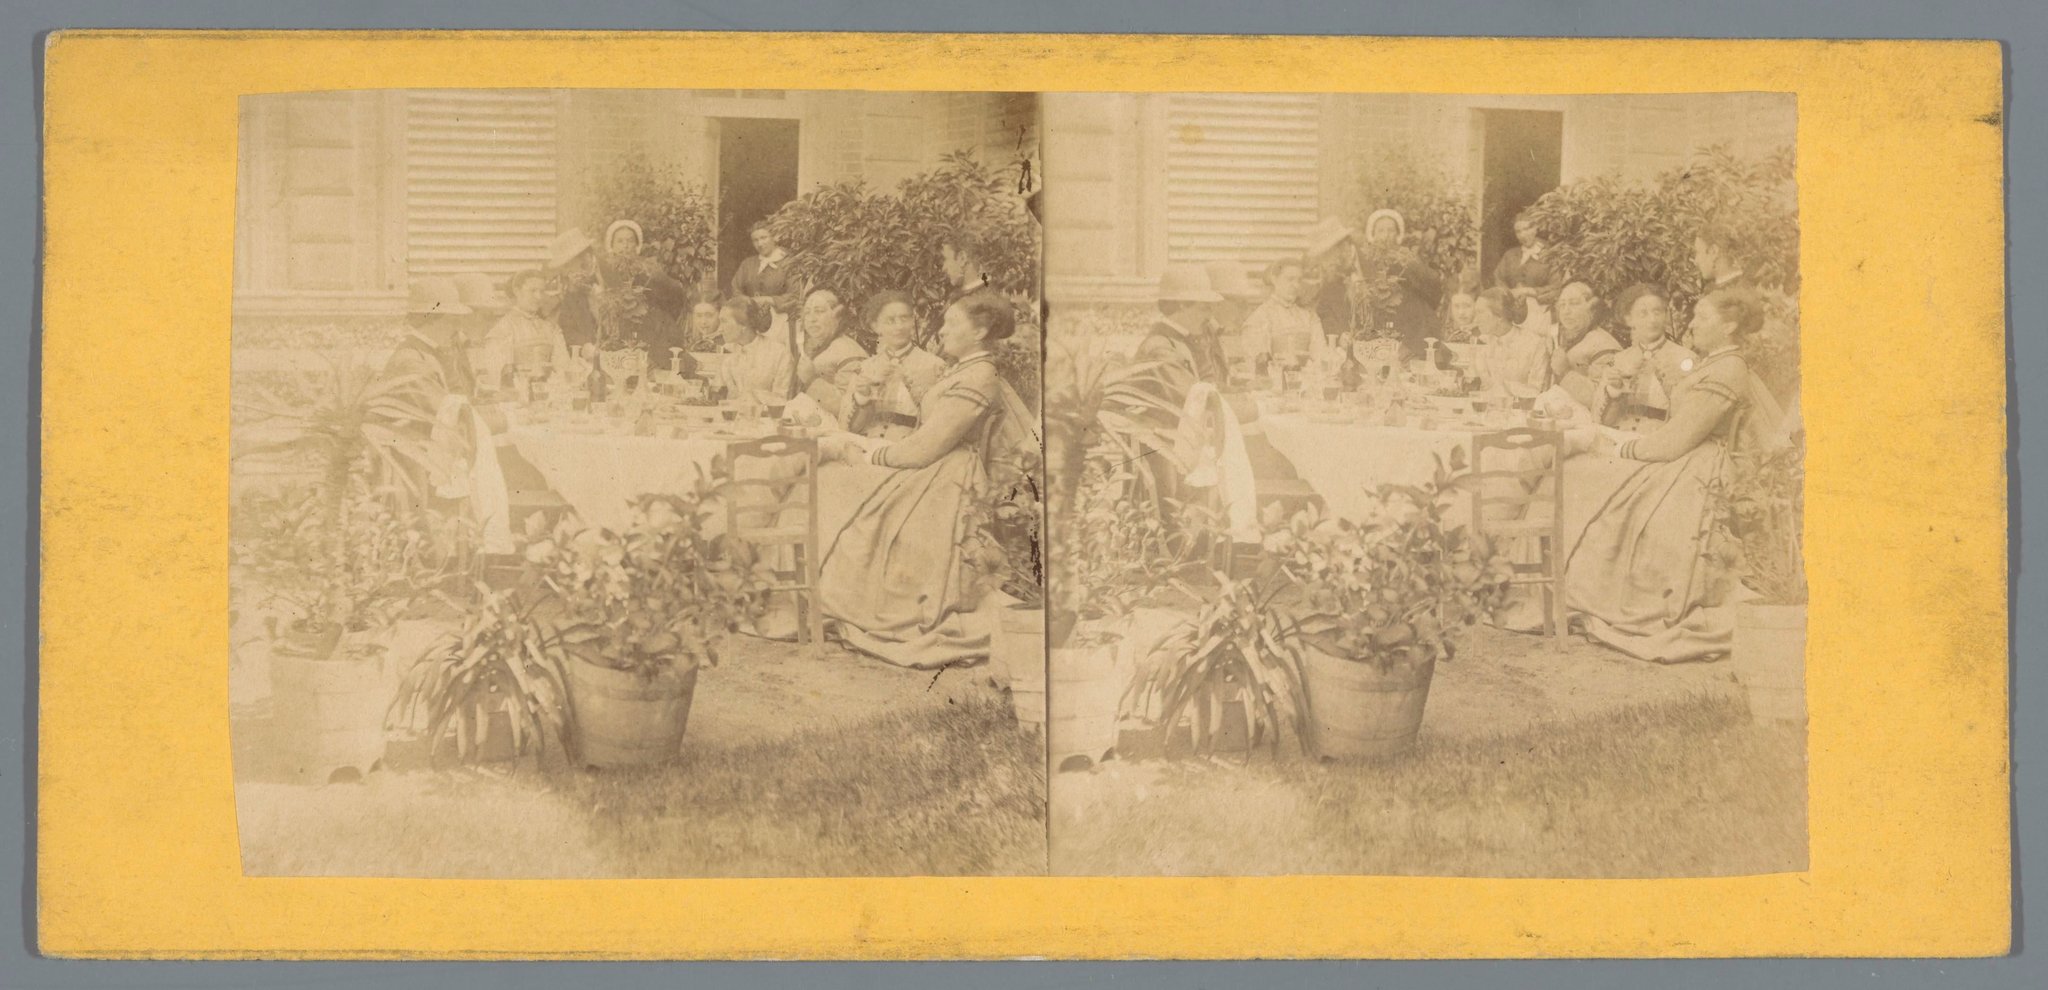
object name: stereograph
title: Gezelschap aan tafel tijdens een diner in een tuin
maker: Anonymous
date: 1850-1880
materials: cardboard, photographic support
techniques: albumen print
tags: evening meal, dinner, supper - cc - out of doors